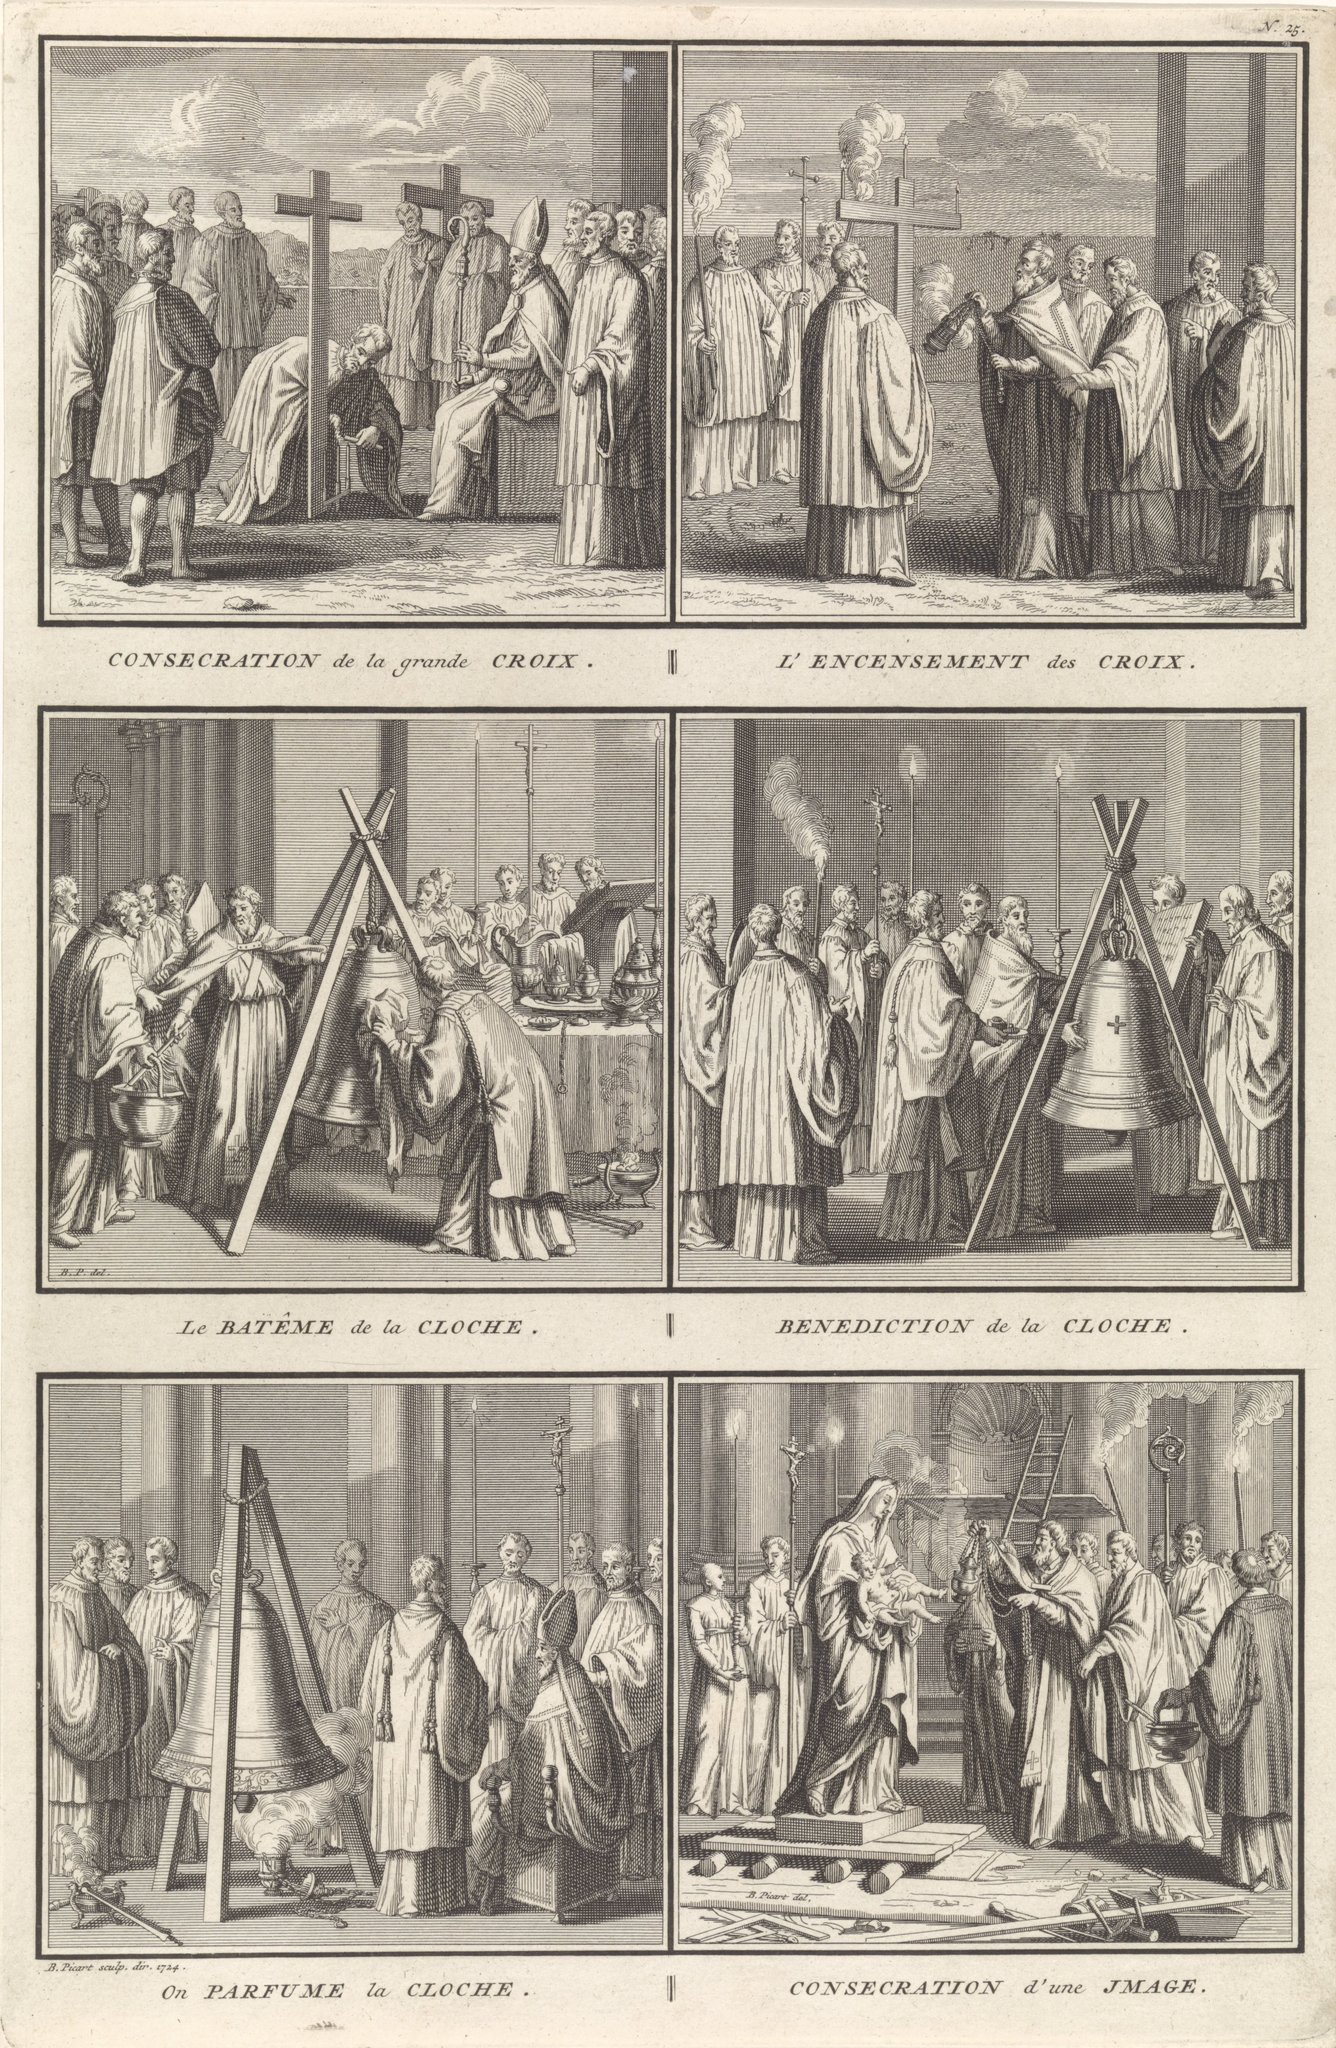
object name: print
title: Wijden van objecten in de rooms-katholieke kerk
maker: bernard picart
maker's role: draughtsman, print maker, publisher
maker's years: 1673-1733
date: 1724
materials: paper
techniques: engraving, etching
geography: amsterdam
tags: ritual consecration ~ christian religion, the cross ~ symbols of christ, church bell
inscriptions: collector's mark: Lugt 2233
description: Blad met zes voorstellingen van het wijden en heiligen van objecten in de rooms-katholieke kerk. Linksboven: De wijding van een groot kruis. Rechtsboven: Bewieroken van een kruis. Links midden: Een nieuwe kerkklok wordt gedoopt. Rechts midden: De klok wordt gezegend. Linksonder: De klok wordt bewierookt. Rechtsonder: Een standbeeld van Maria met Christuskind wordt gewijd. Rechtsboven genummerd: N. 25.